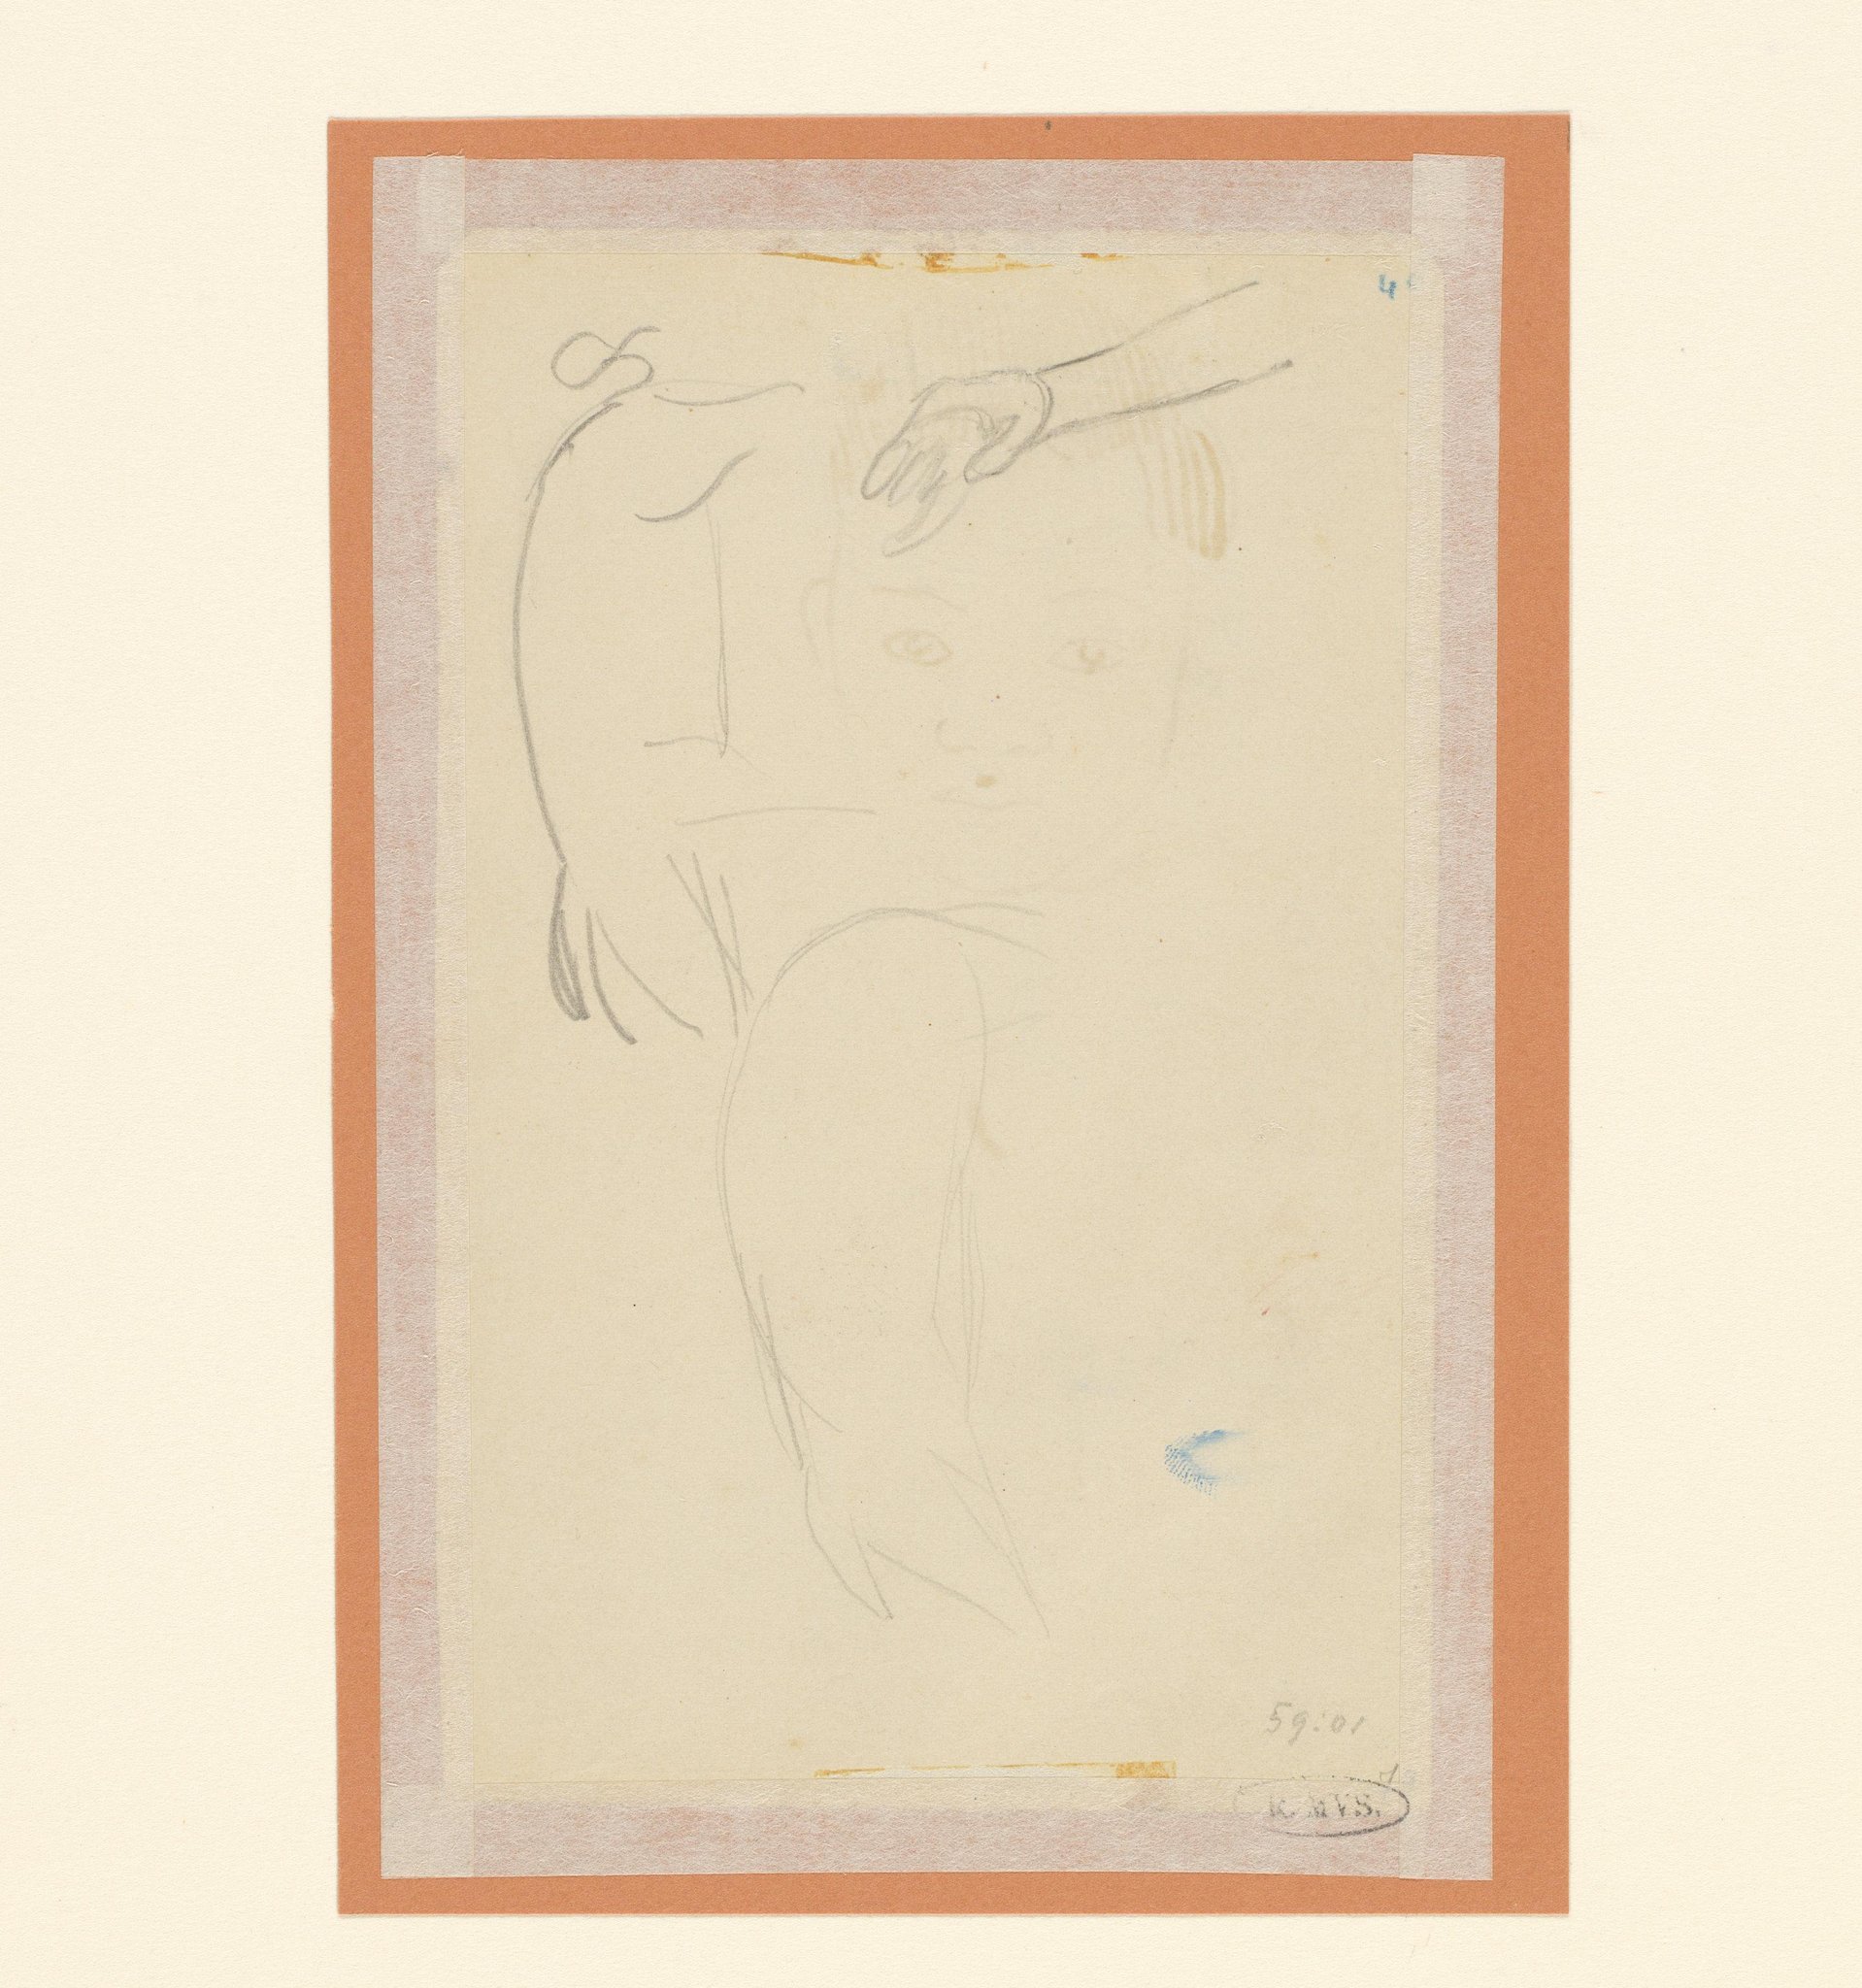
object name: drawing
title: Twee varkens en een hand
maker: paul gauguin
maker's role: draughtsman, print maker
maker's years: 1848-1903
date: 1858-1903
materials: paper, pencil